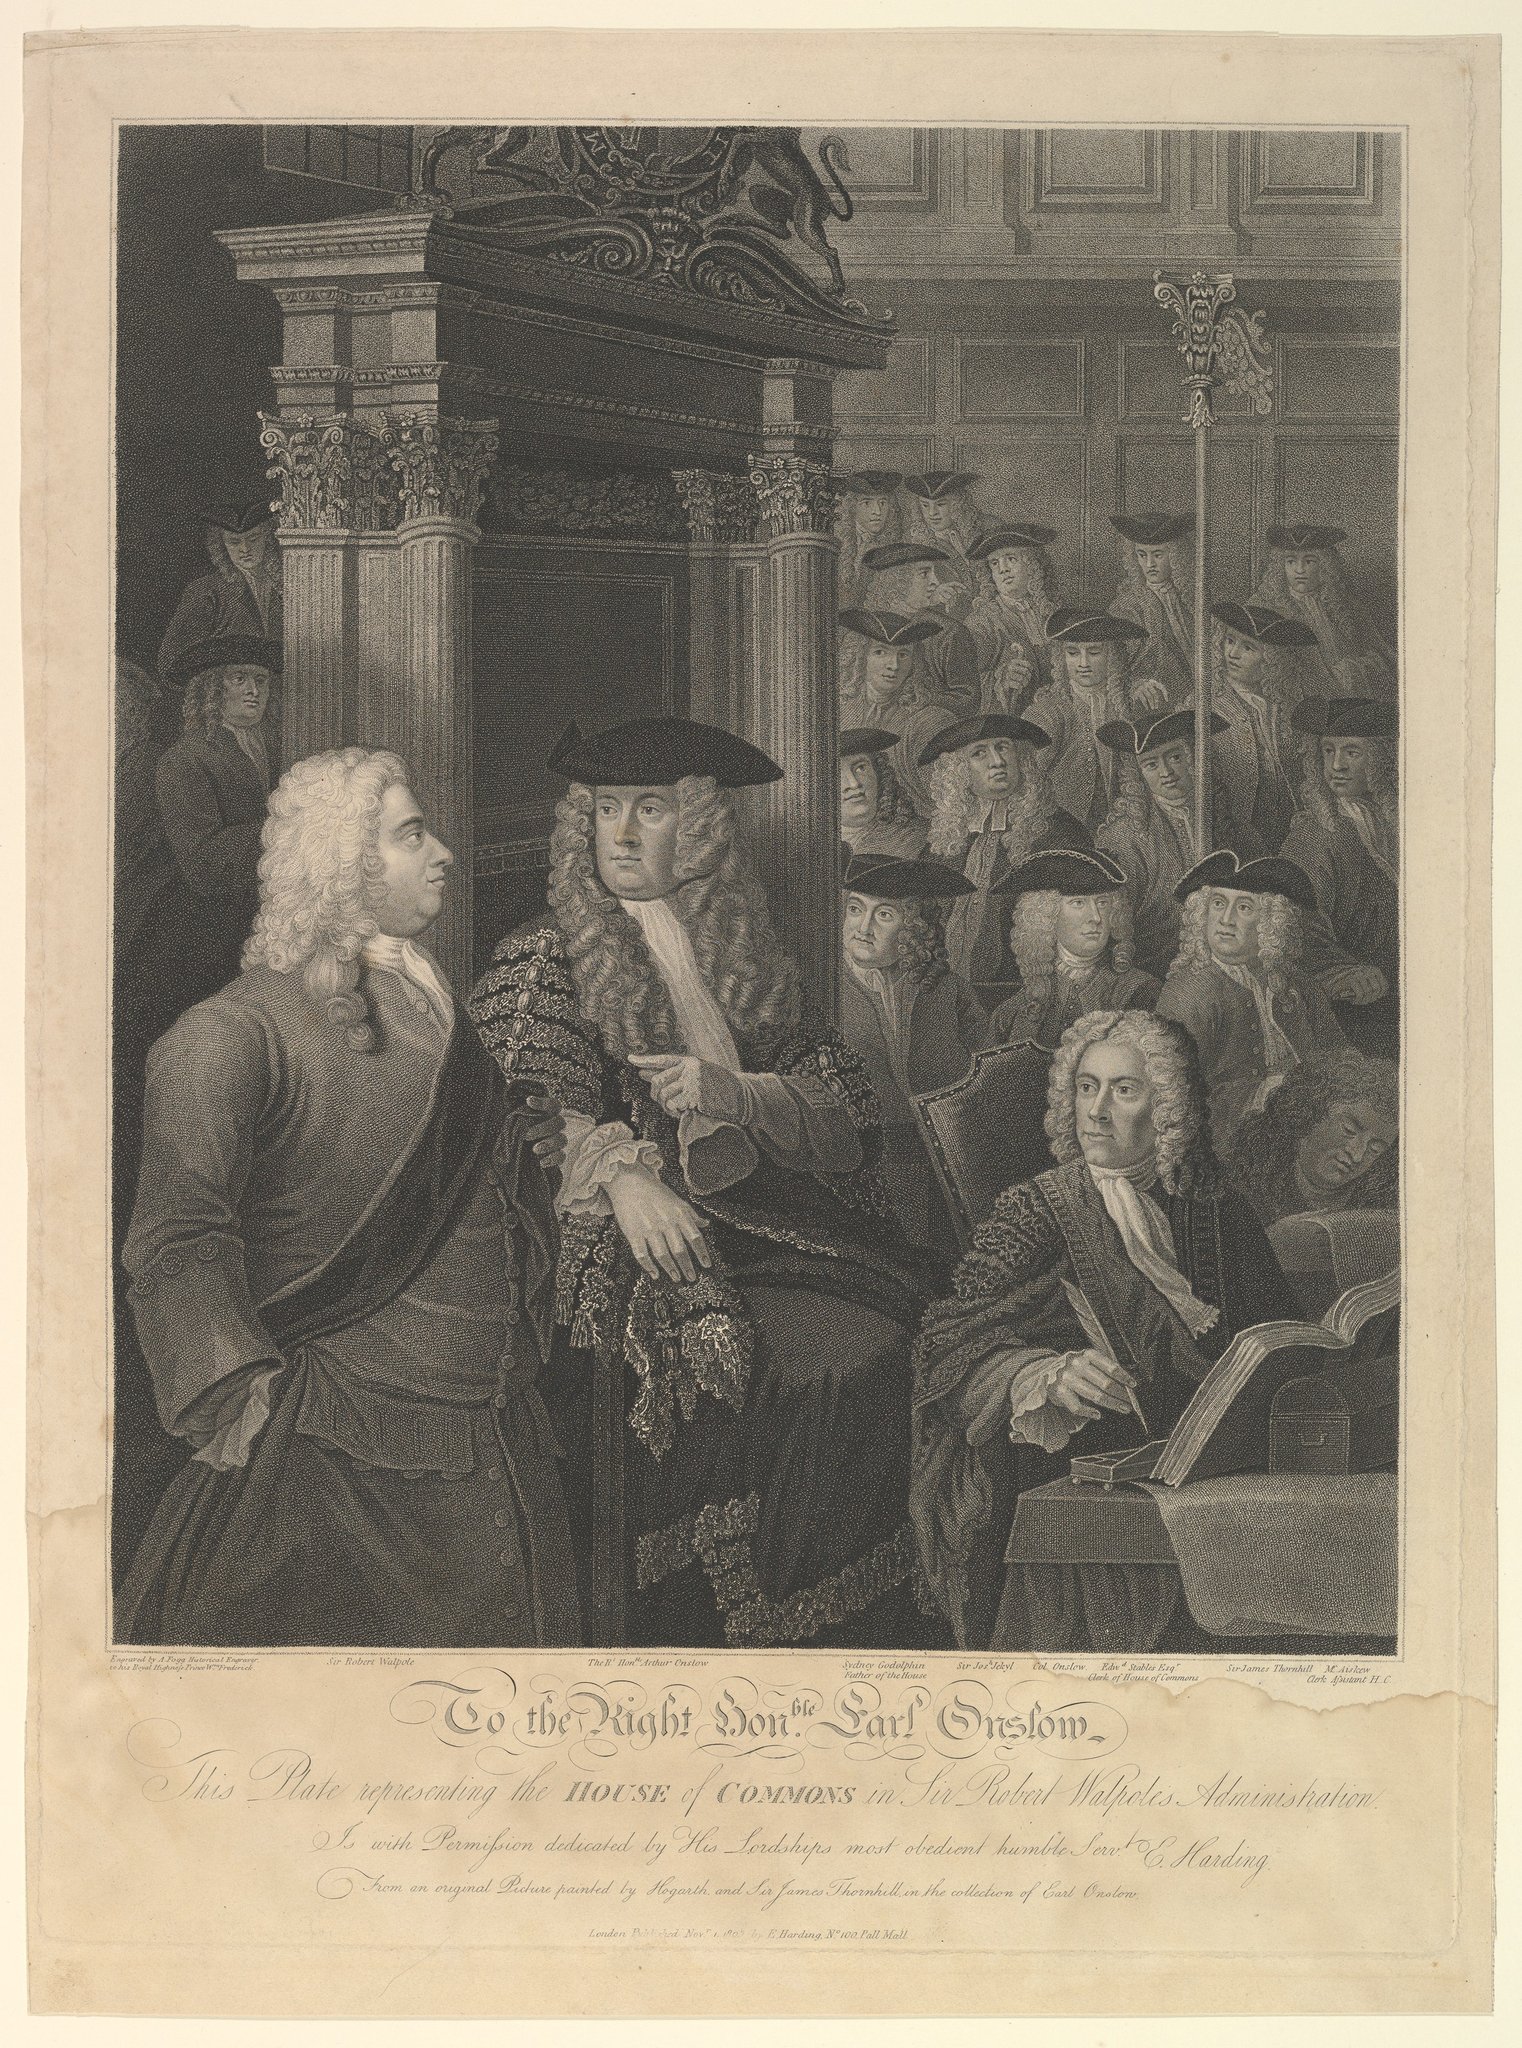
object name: print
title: House of Commons - Sir Robert Walpole's Administration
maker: anthony fogg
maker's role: engraver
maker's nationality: british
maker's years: 1792-1806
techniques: etching, engraving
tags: men